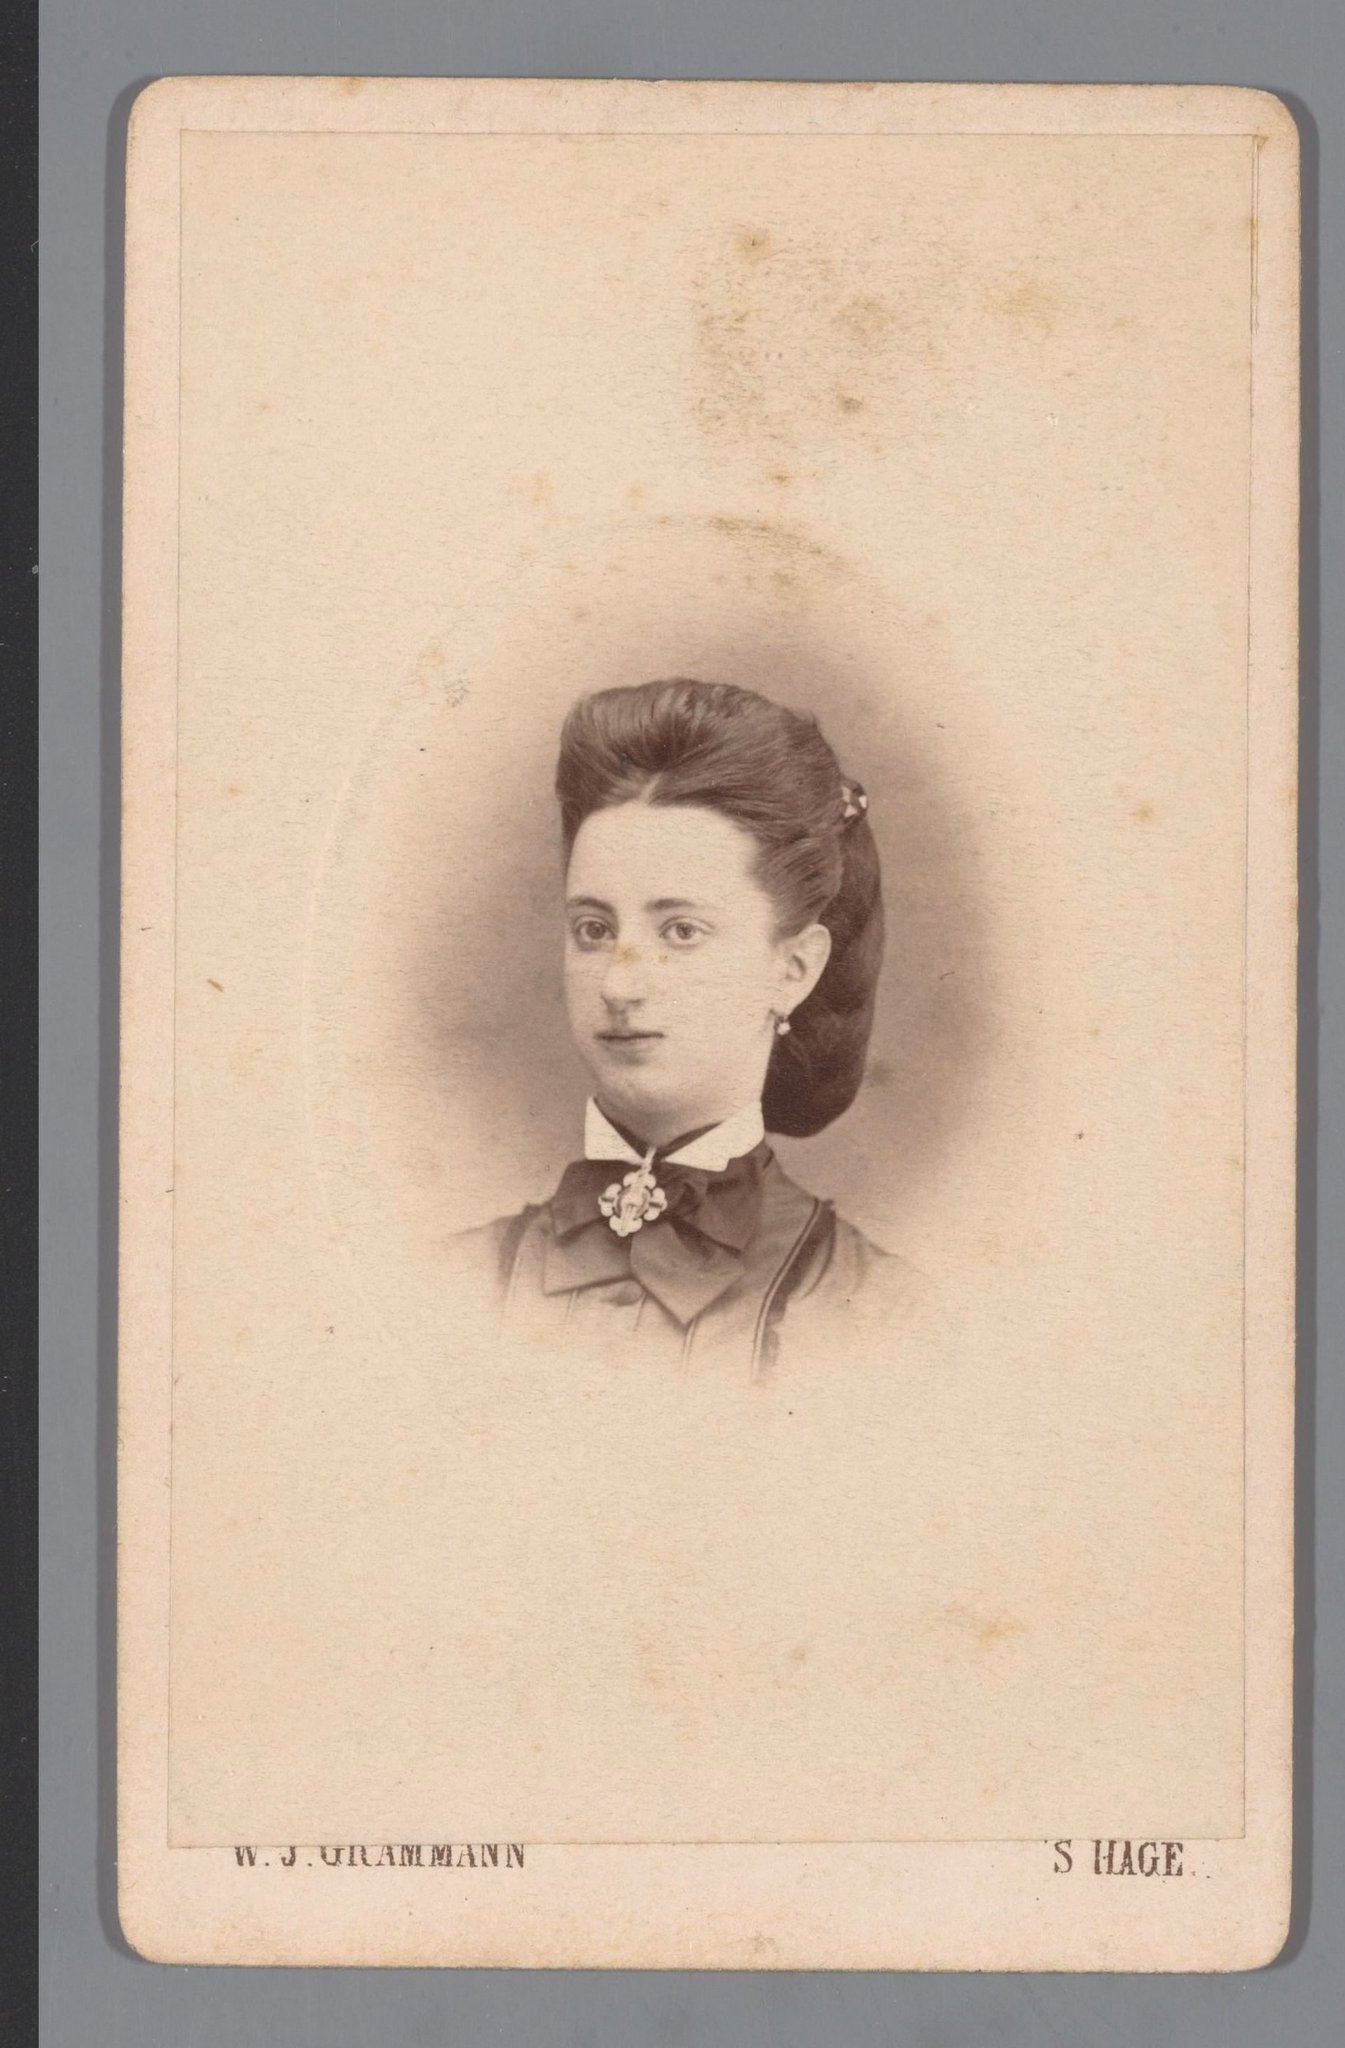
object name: carte de visite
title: Portret van een vrouw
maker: wilhelm j. grammann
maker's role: fotograaf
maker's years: 1844-1874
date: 1870-1874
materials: cardboard, paper, photographic support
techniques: albumen print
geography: the hague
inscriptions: signature: ‘Photogr. W.J.G. Atelier’, annotation: ‘Voor nabestellingen worden de/origineele platen bewaard’, signature and address: ‘W.J. Grammann/Photographie/12 Willemstraat 12/'s Hage’